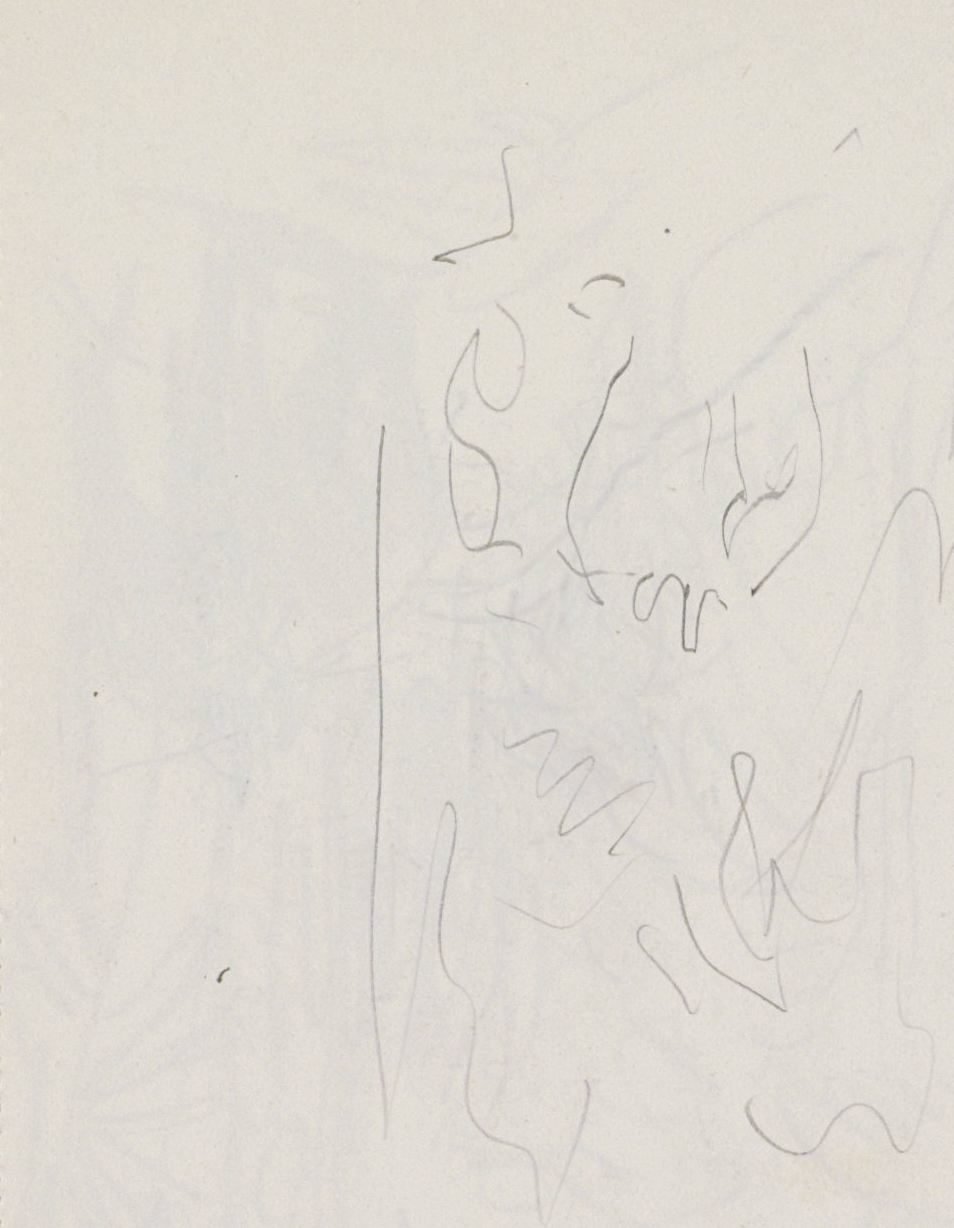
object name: sketchbook leaf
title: Studie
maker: marius bauer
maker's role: draughtsman, print maker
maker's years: 1867-1932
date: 1924-1925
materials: paper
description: Pagina 145 uit een schetsboek met 75 bladen.